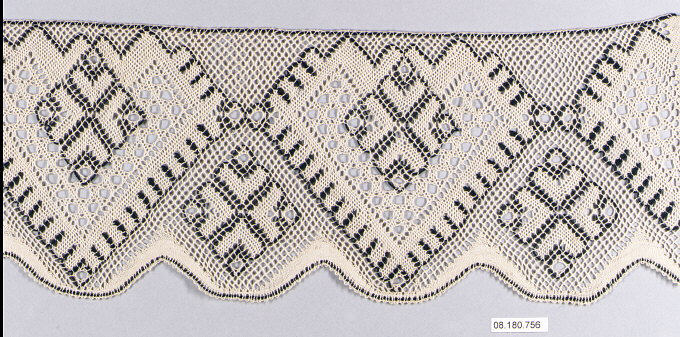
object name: piece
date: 1801-1900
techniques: lace